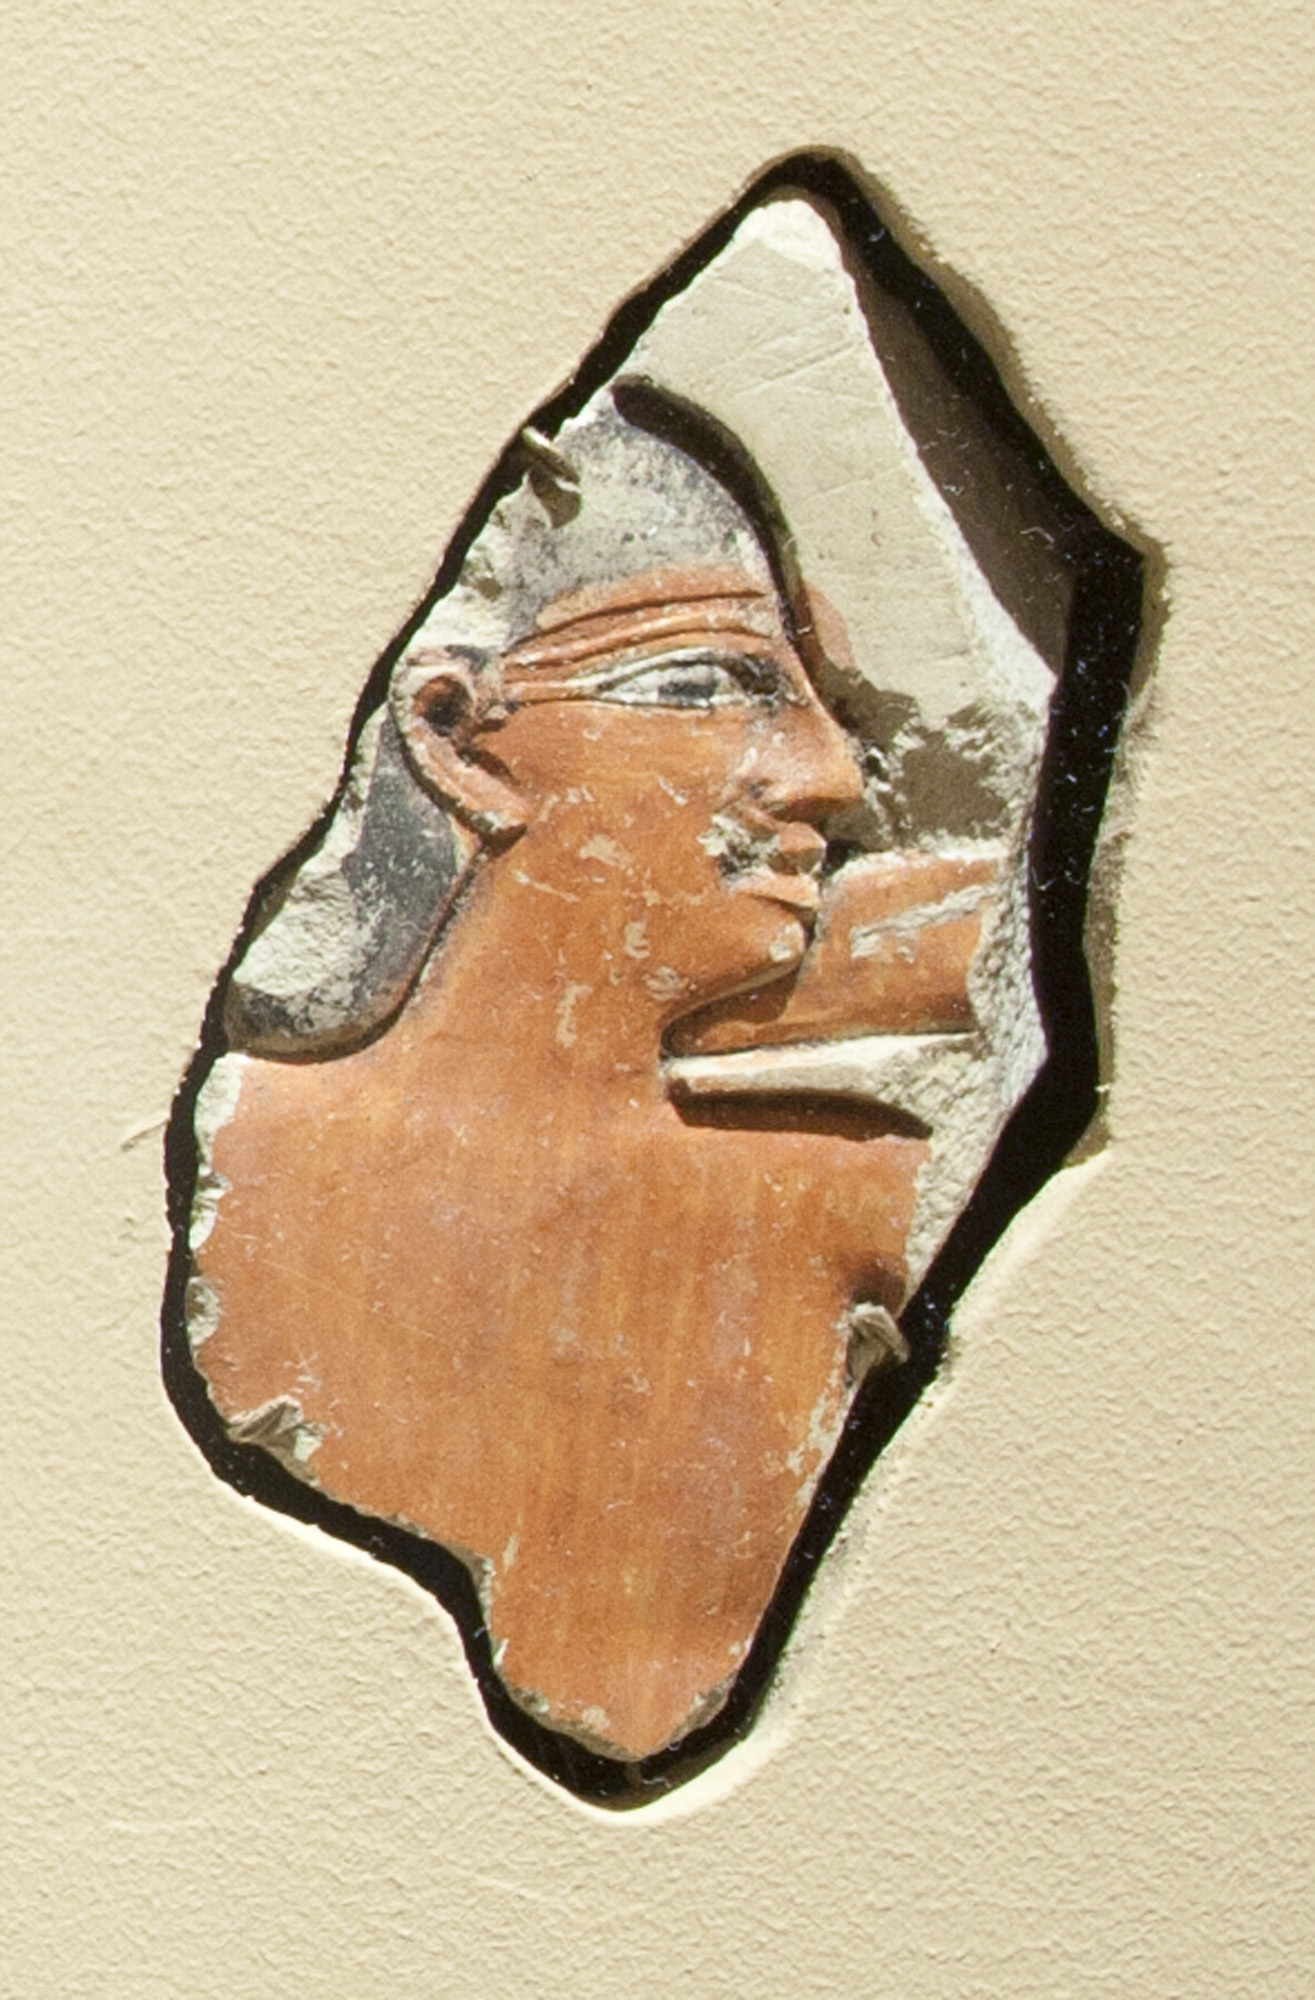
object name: relief, tomb of khety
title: Part of a male figure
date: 2051-2000 BCE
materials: limestone, paint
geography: egypt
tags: men